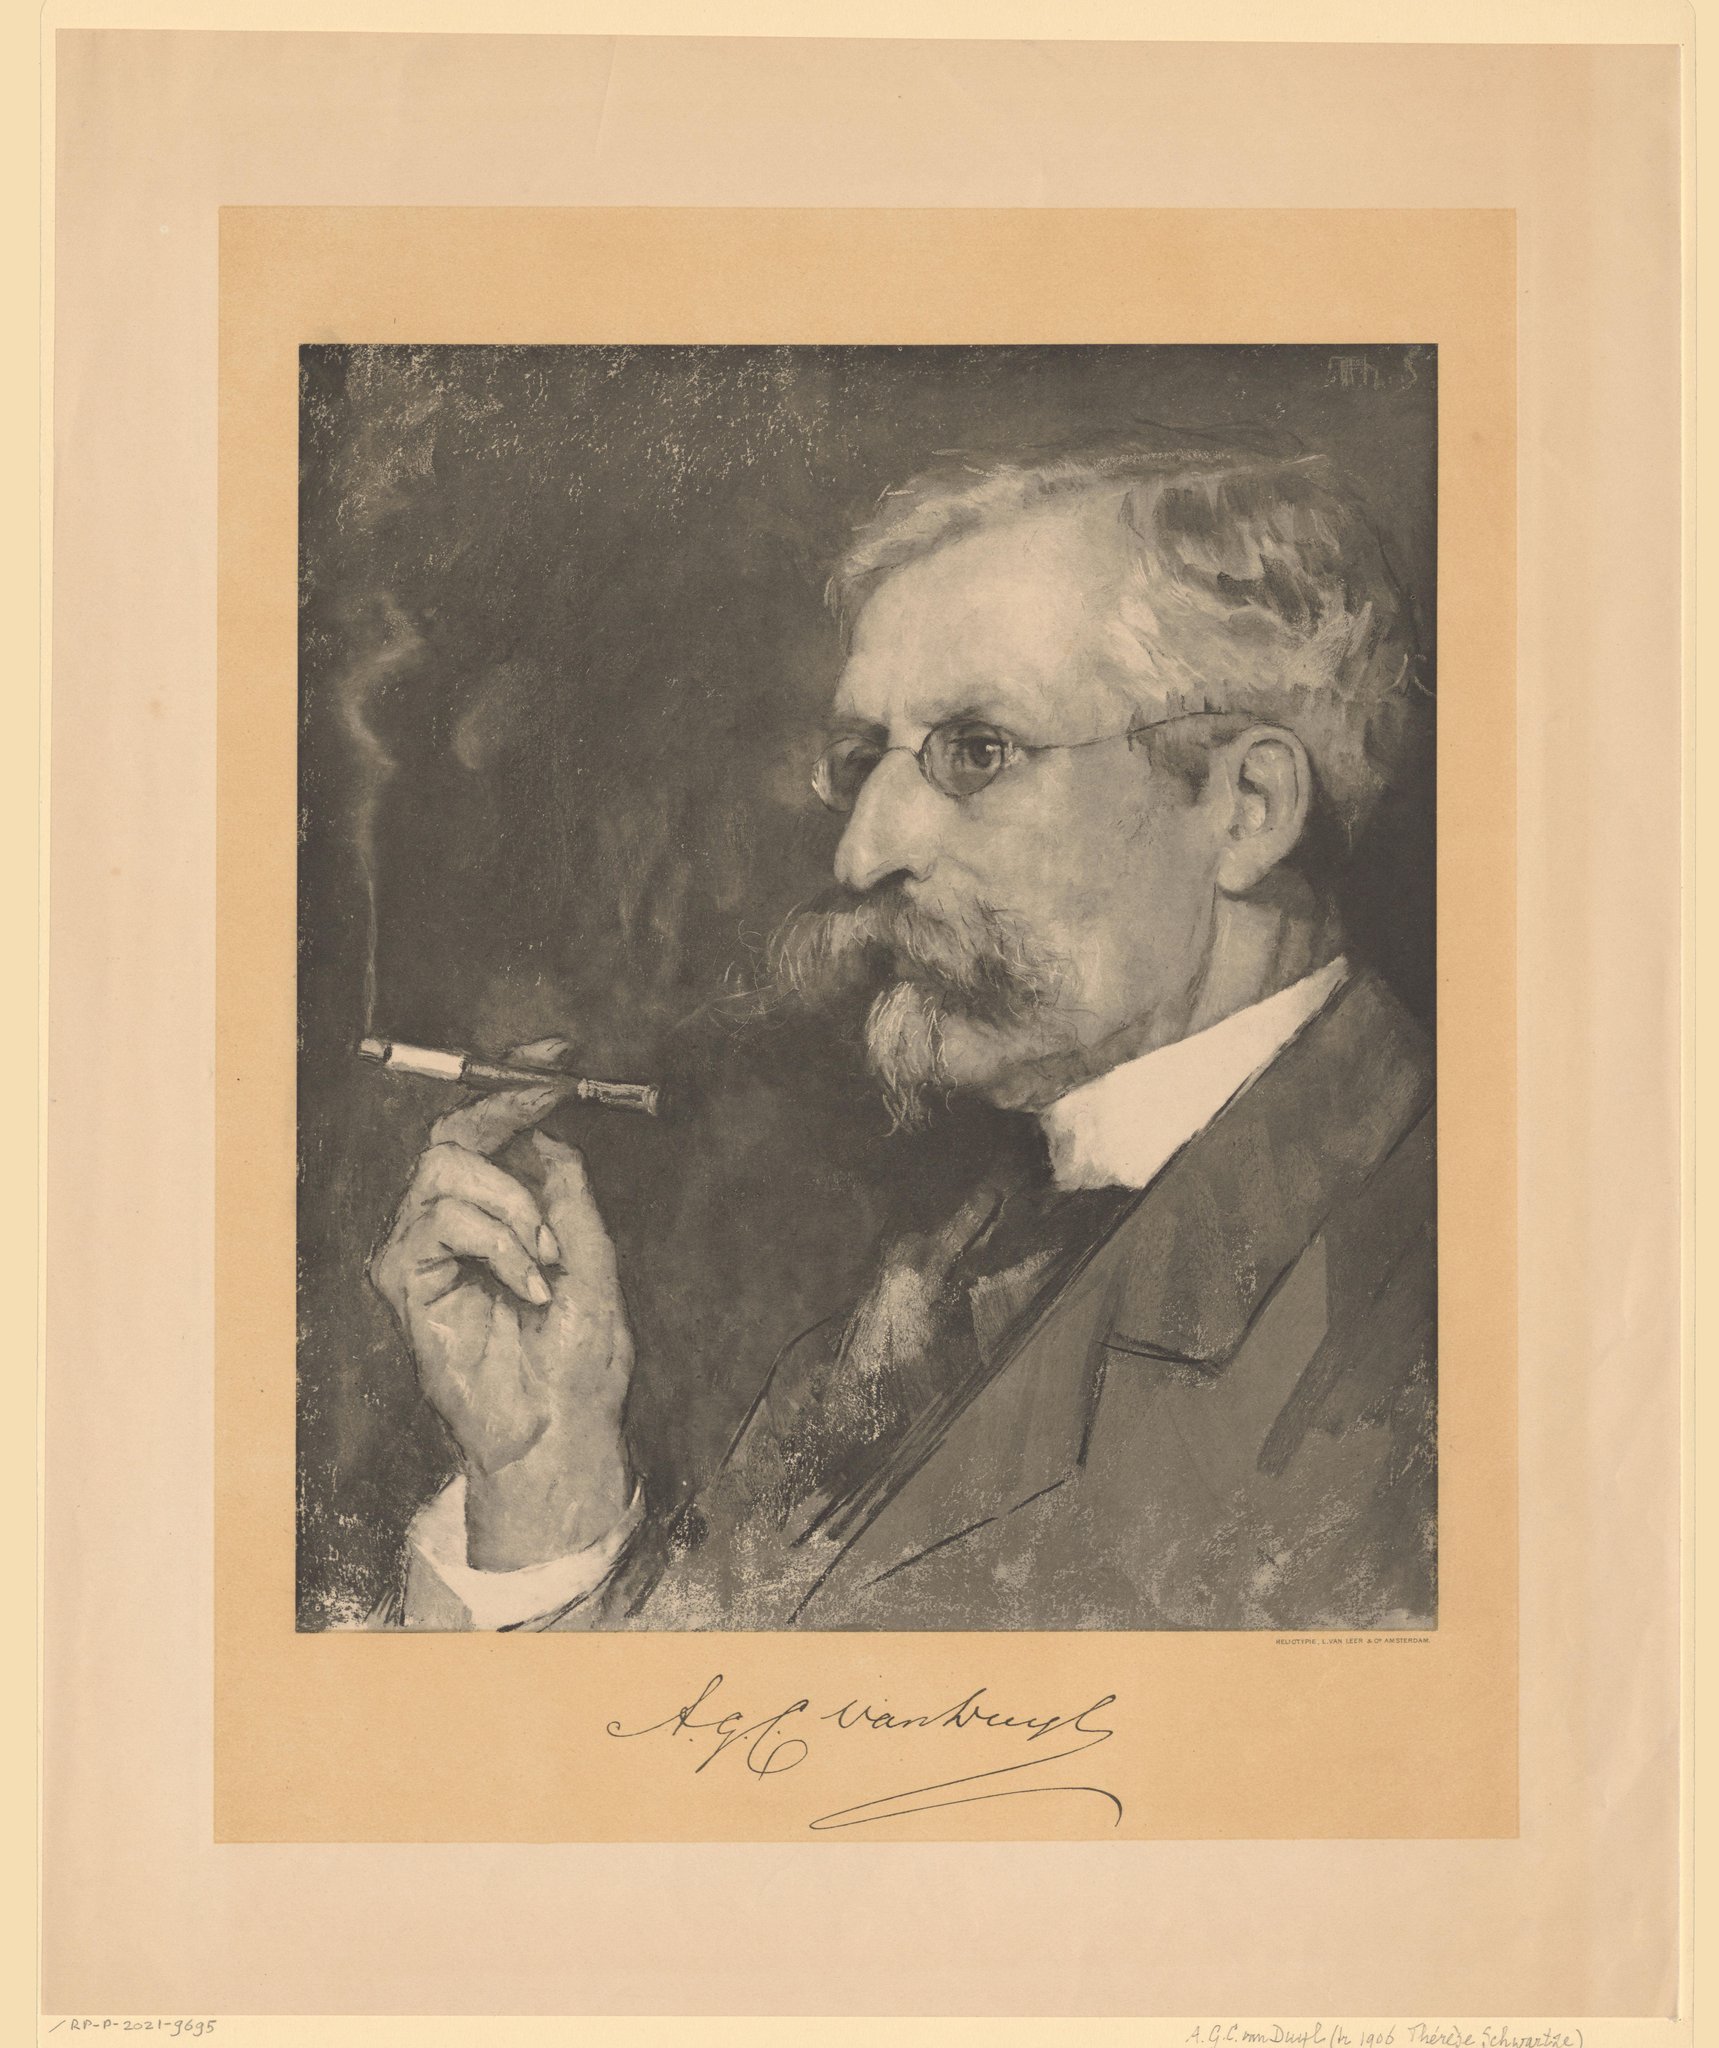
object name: photomechanical print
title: Portret van Anton Gilles Cornelis van Duyl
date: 1888-1966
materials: paper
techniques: photograph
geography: amsterdam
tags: brielle, anton gilles cornelis van duyl, cigarette, historical persons, portrait of a writer